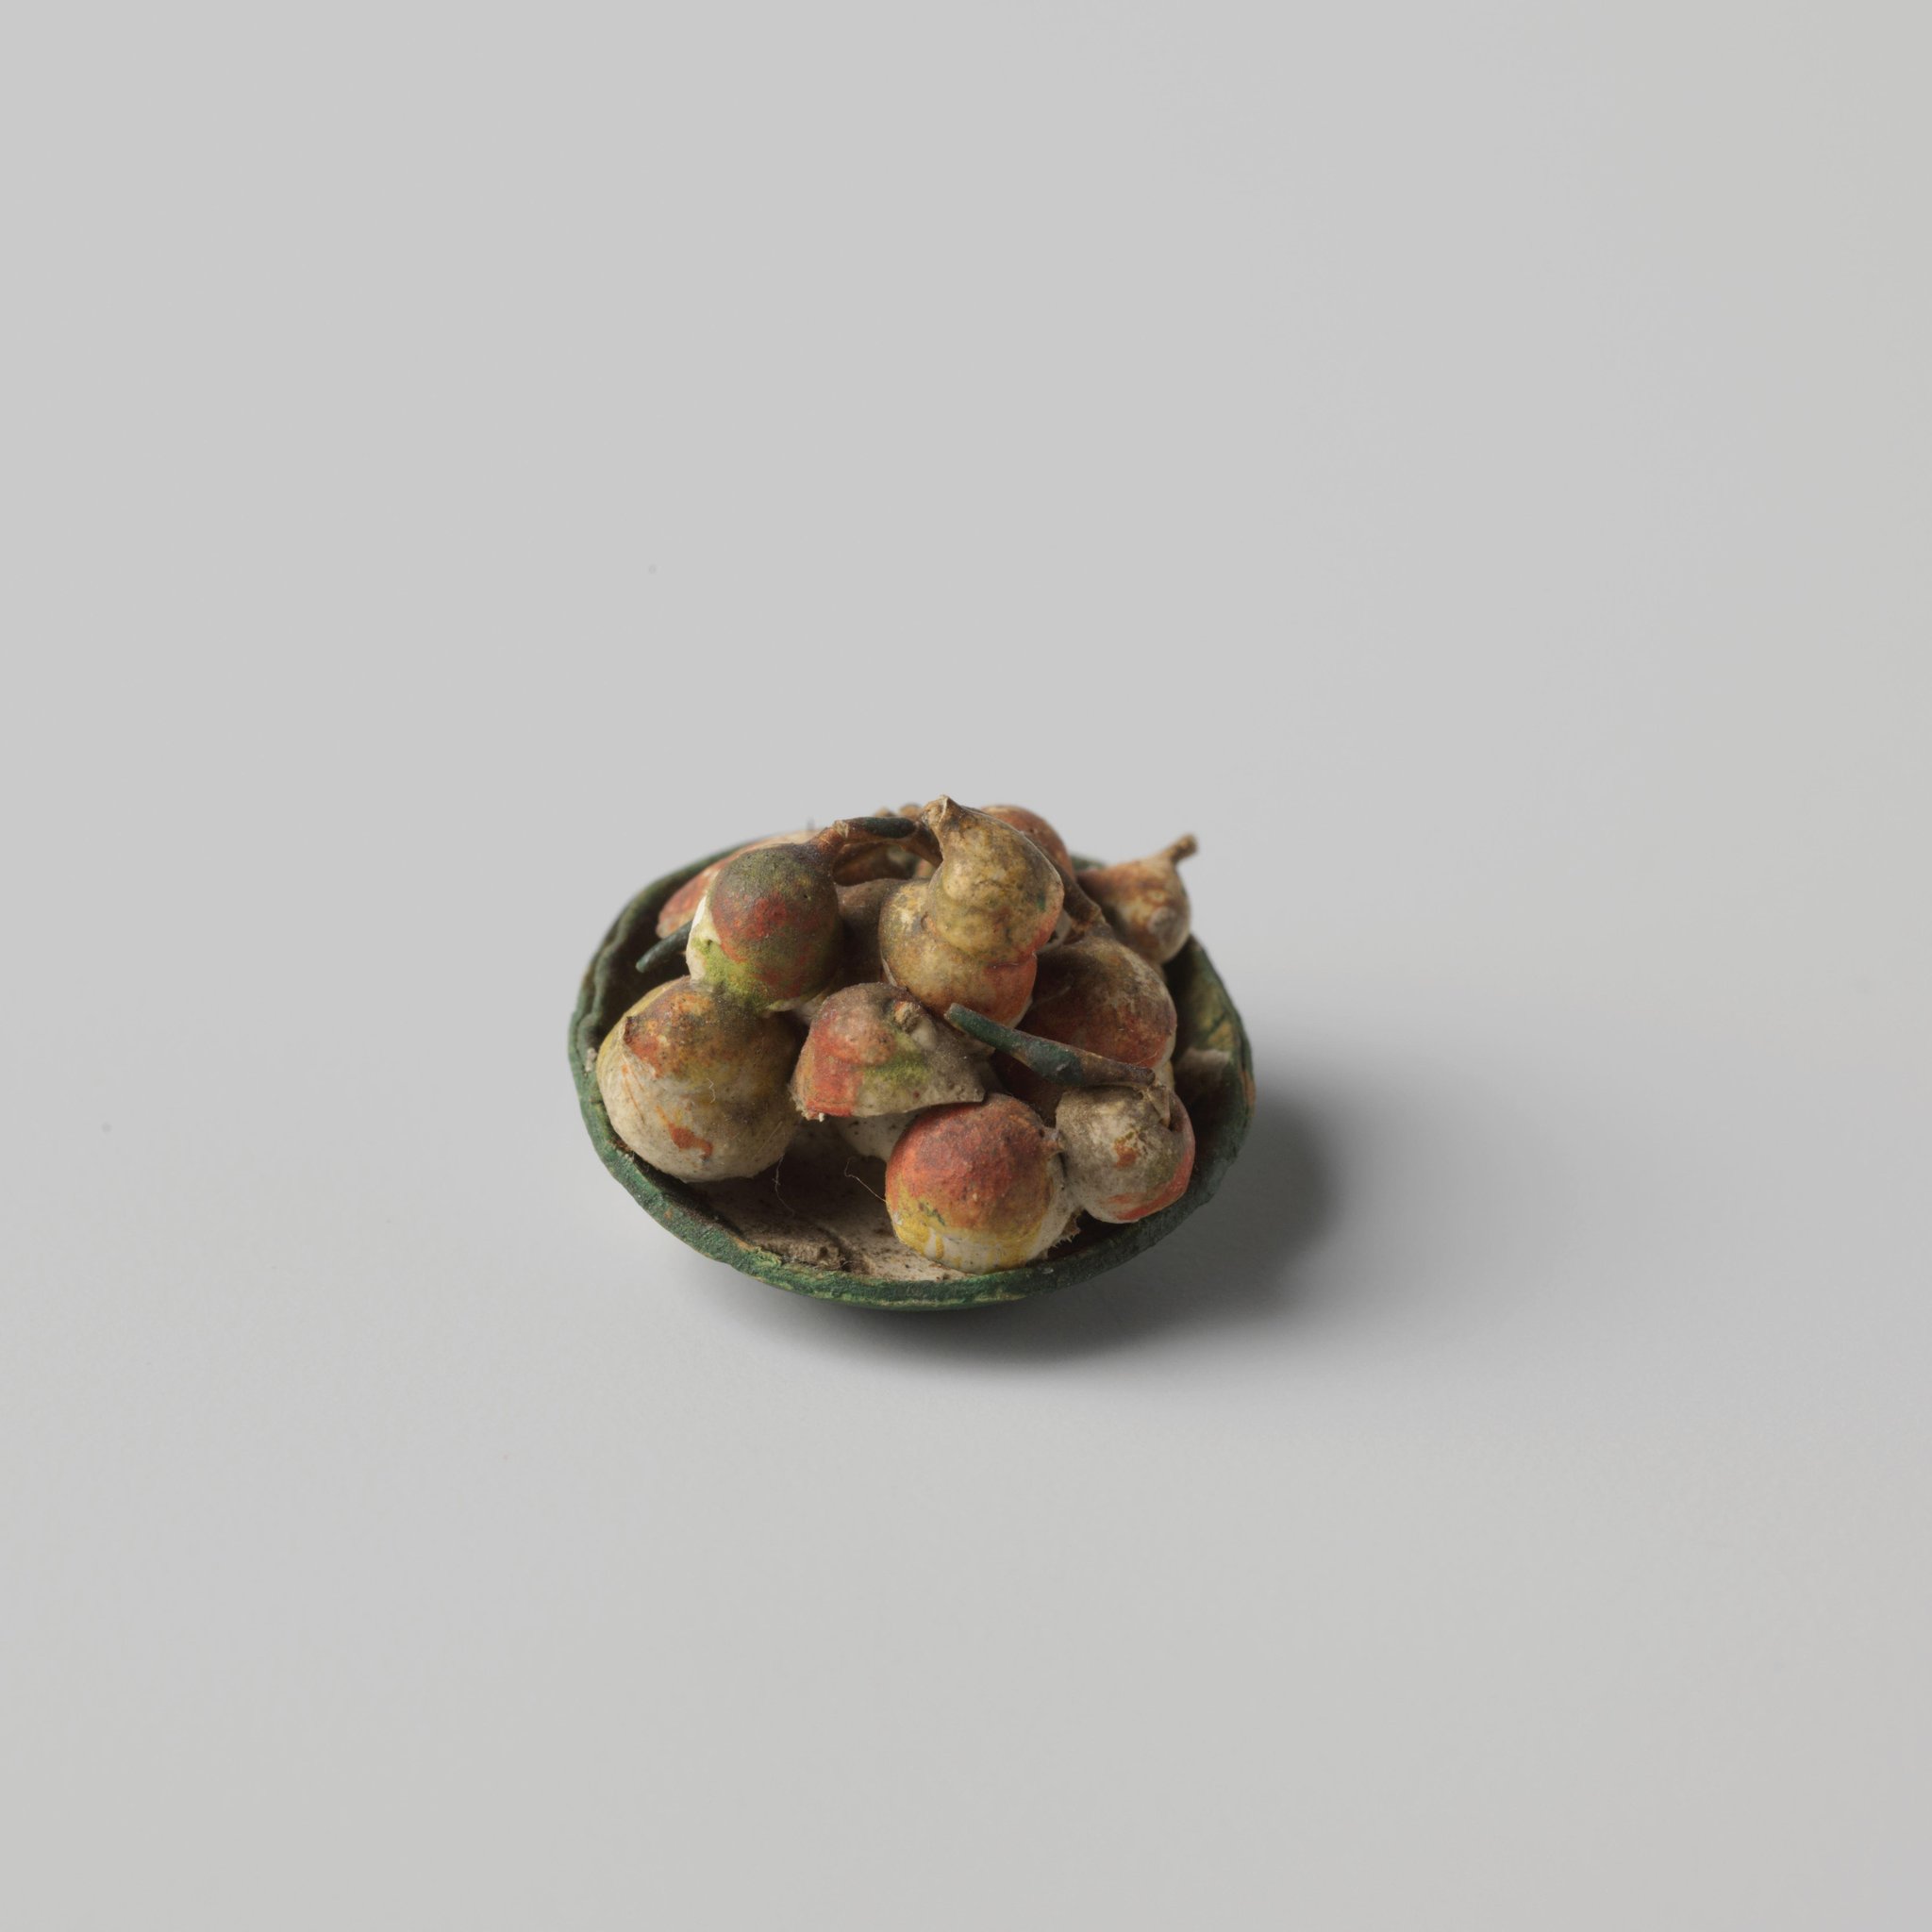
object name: miniature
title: Bak met fruit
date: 1700-1799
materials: paper, papier mâché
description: Groengeverfde papieren ronde schotel met vruchten met steeltjes, gemaakt van onduidelijke substantie.